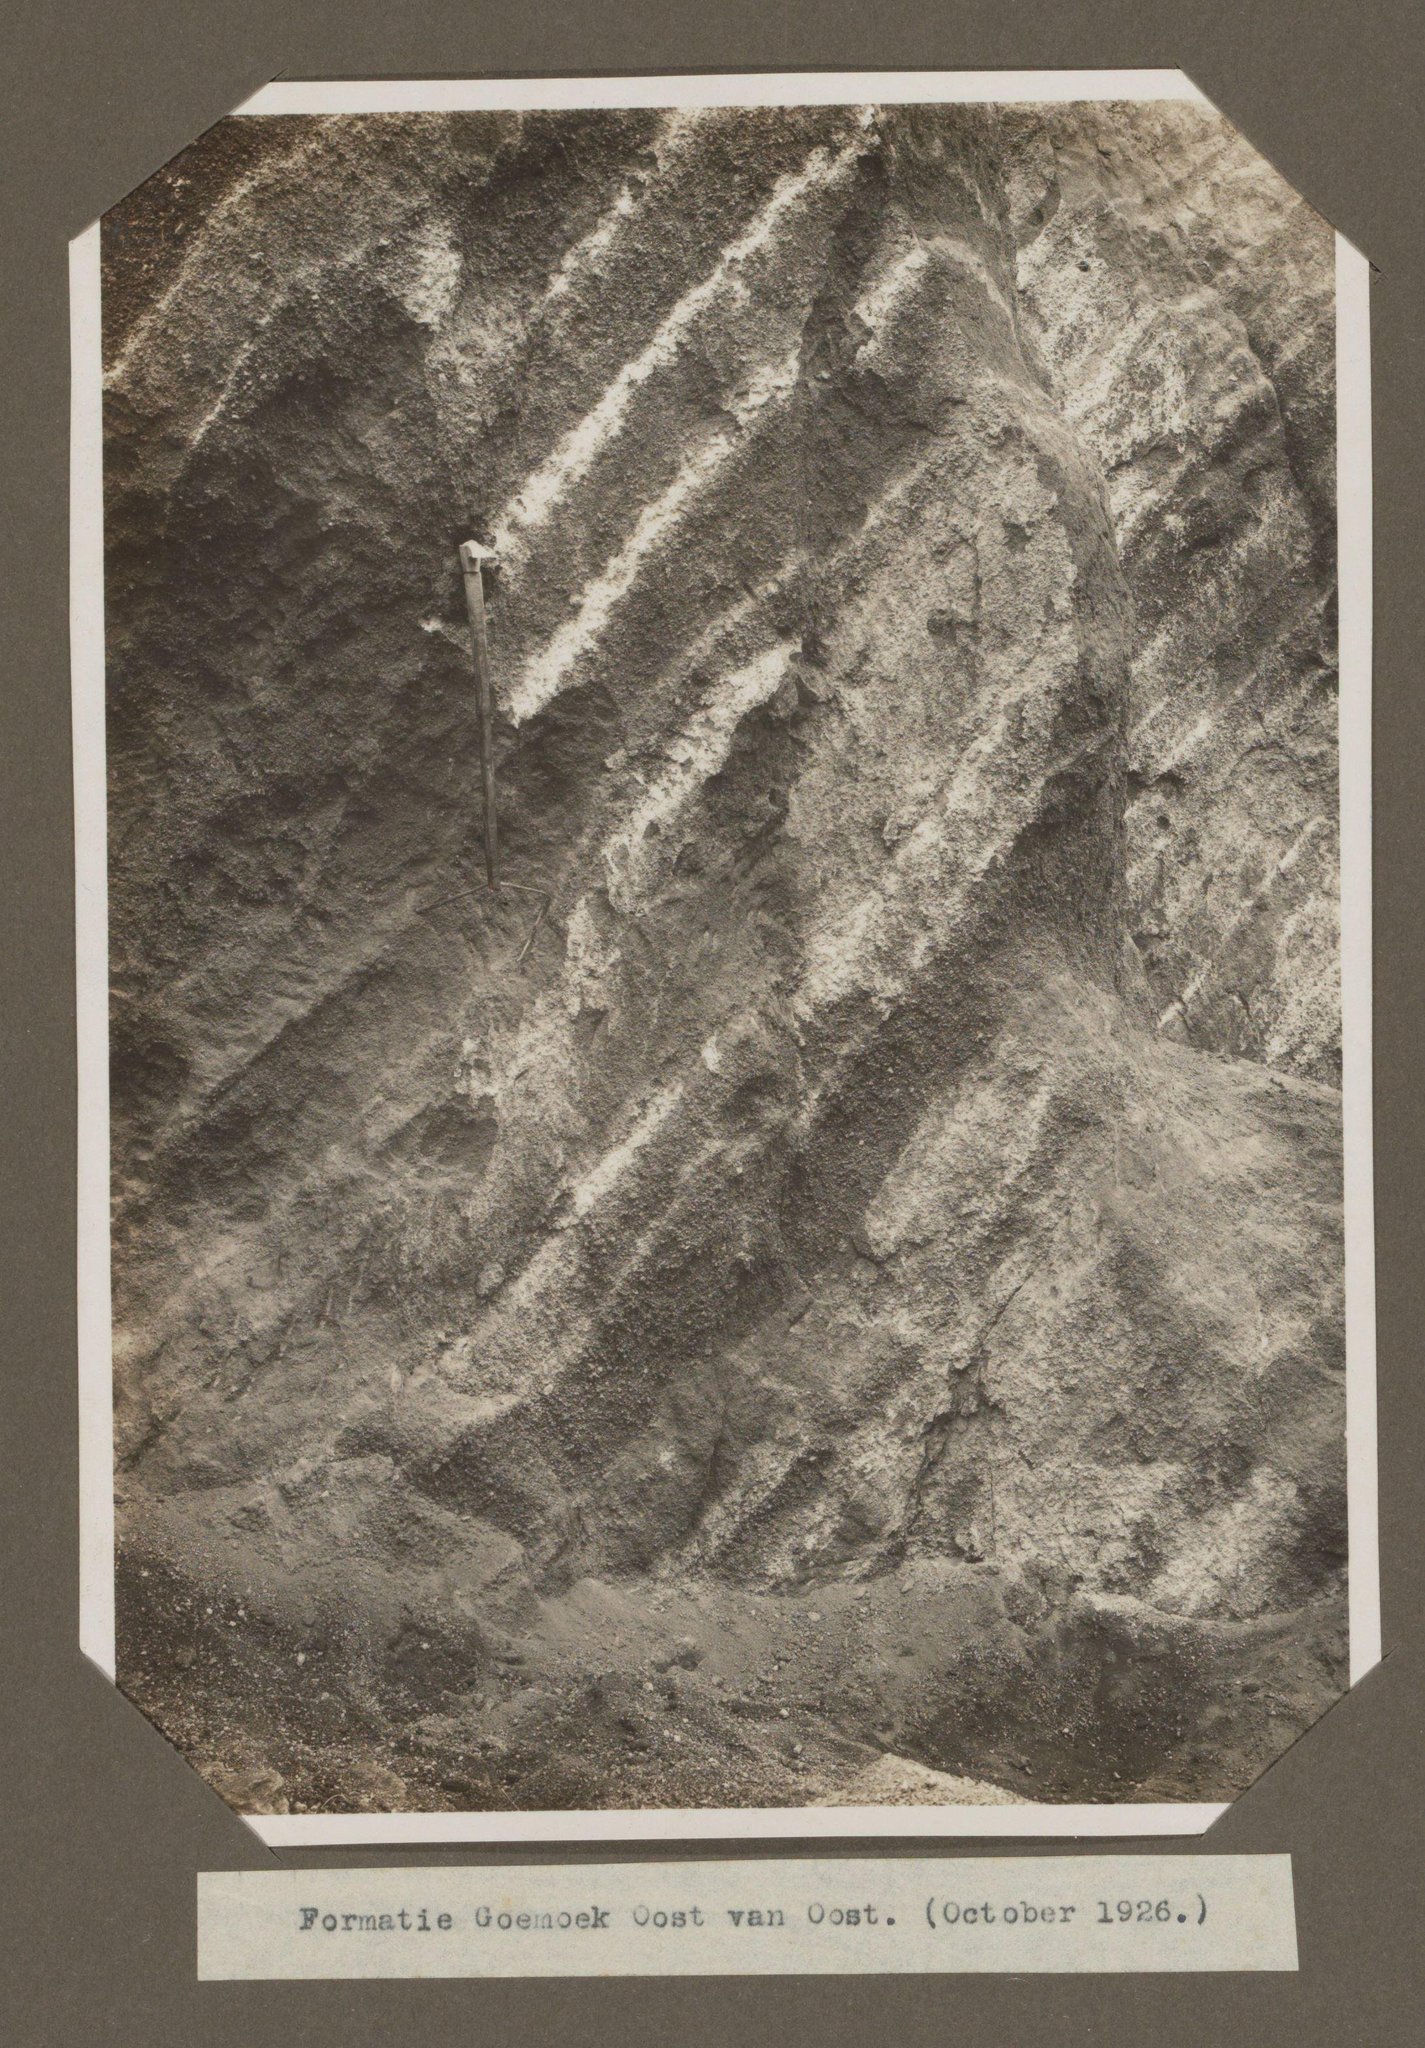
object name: photograph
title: Formatie Goemoek Oost van Oost. (October 1926.)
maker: Anonymous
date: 1910-1926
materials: photographic support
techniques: gelatin silver print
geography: east java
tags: colonial system, trade-company, (non-fruit) products of plants or trees: sugarcane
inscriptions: inscription: ‘Uitgegraven goemoek op Oost van Oost. (October 1926.)’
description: Detail van de wand van de deels uitgegraven versteningen in de aarden heuvel (goemoek) op Oost van Oost, waarschijnlijk gelegen op het fabrieksterrein, oktober 1926. Onderdeel van het fotoalbum met foto's van de opbouw van de suikerfabriek te Goenoengsari op Oost-Java door de Handels Vereniging Amsterdam 1926-1927.